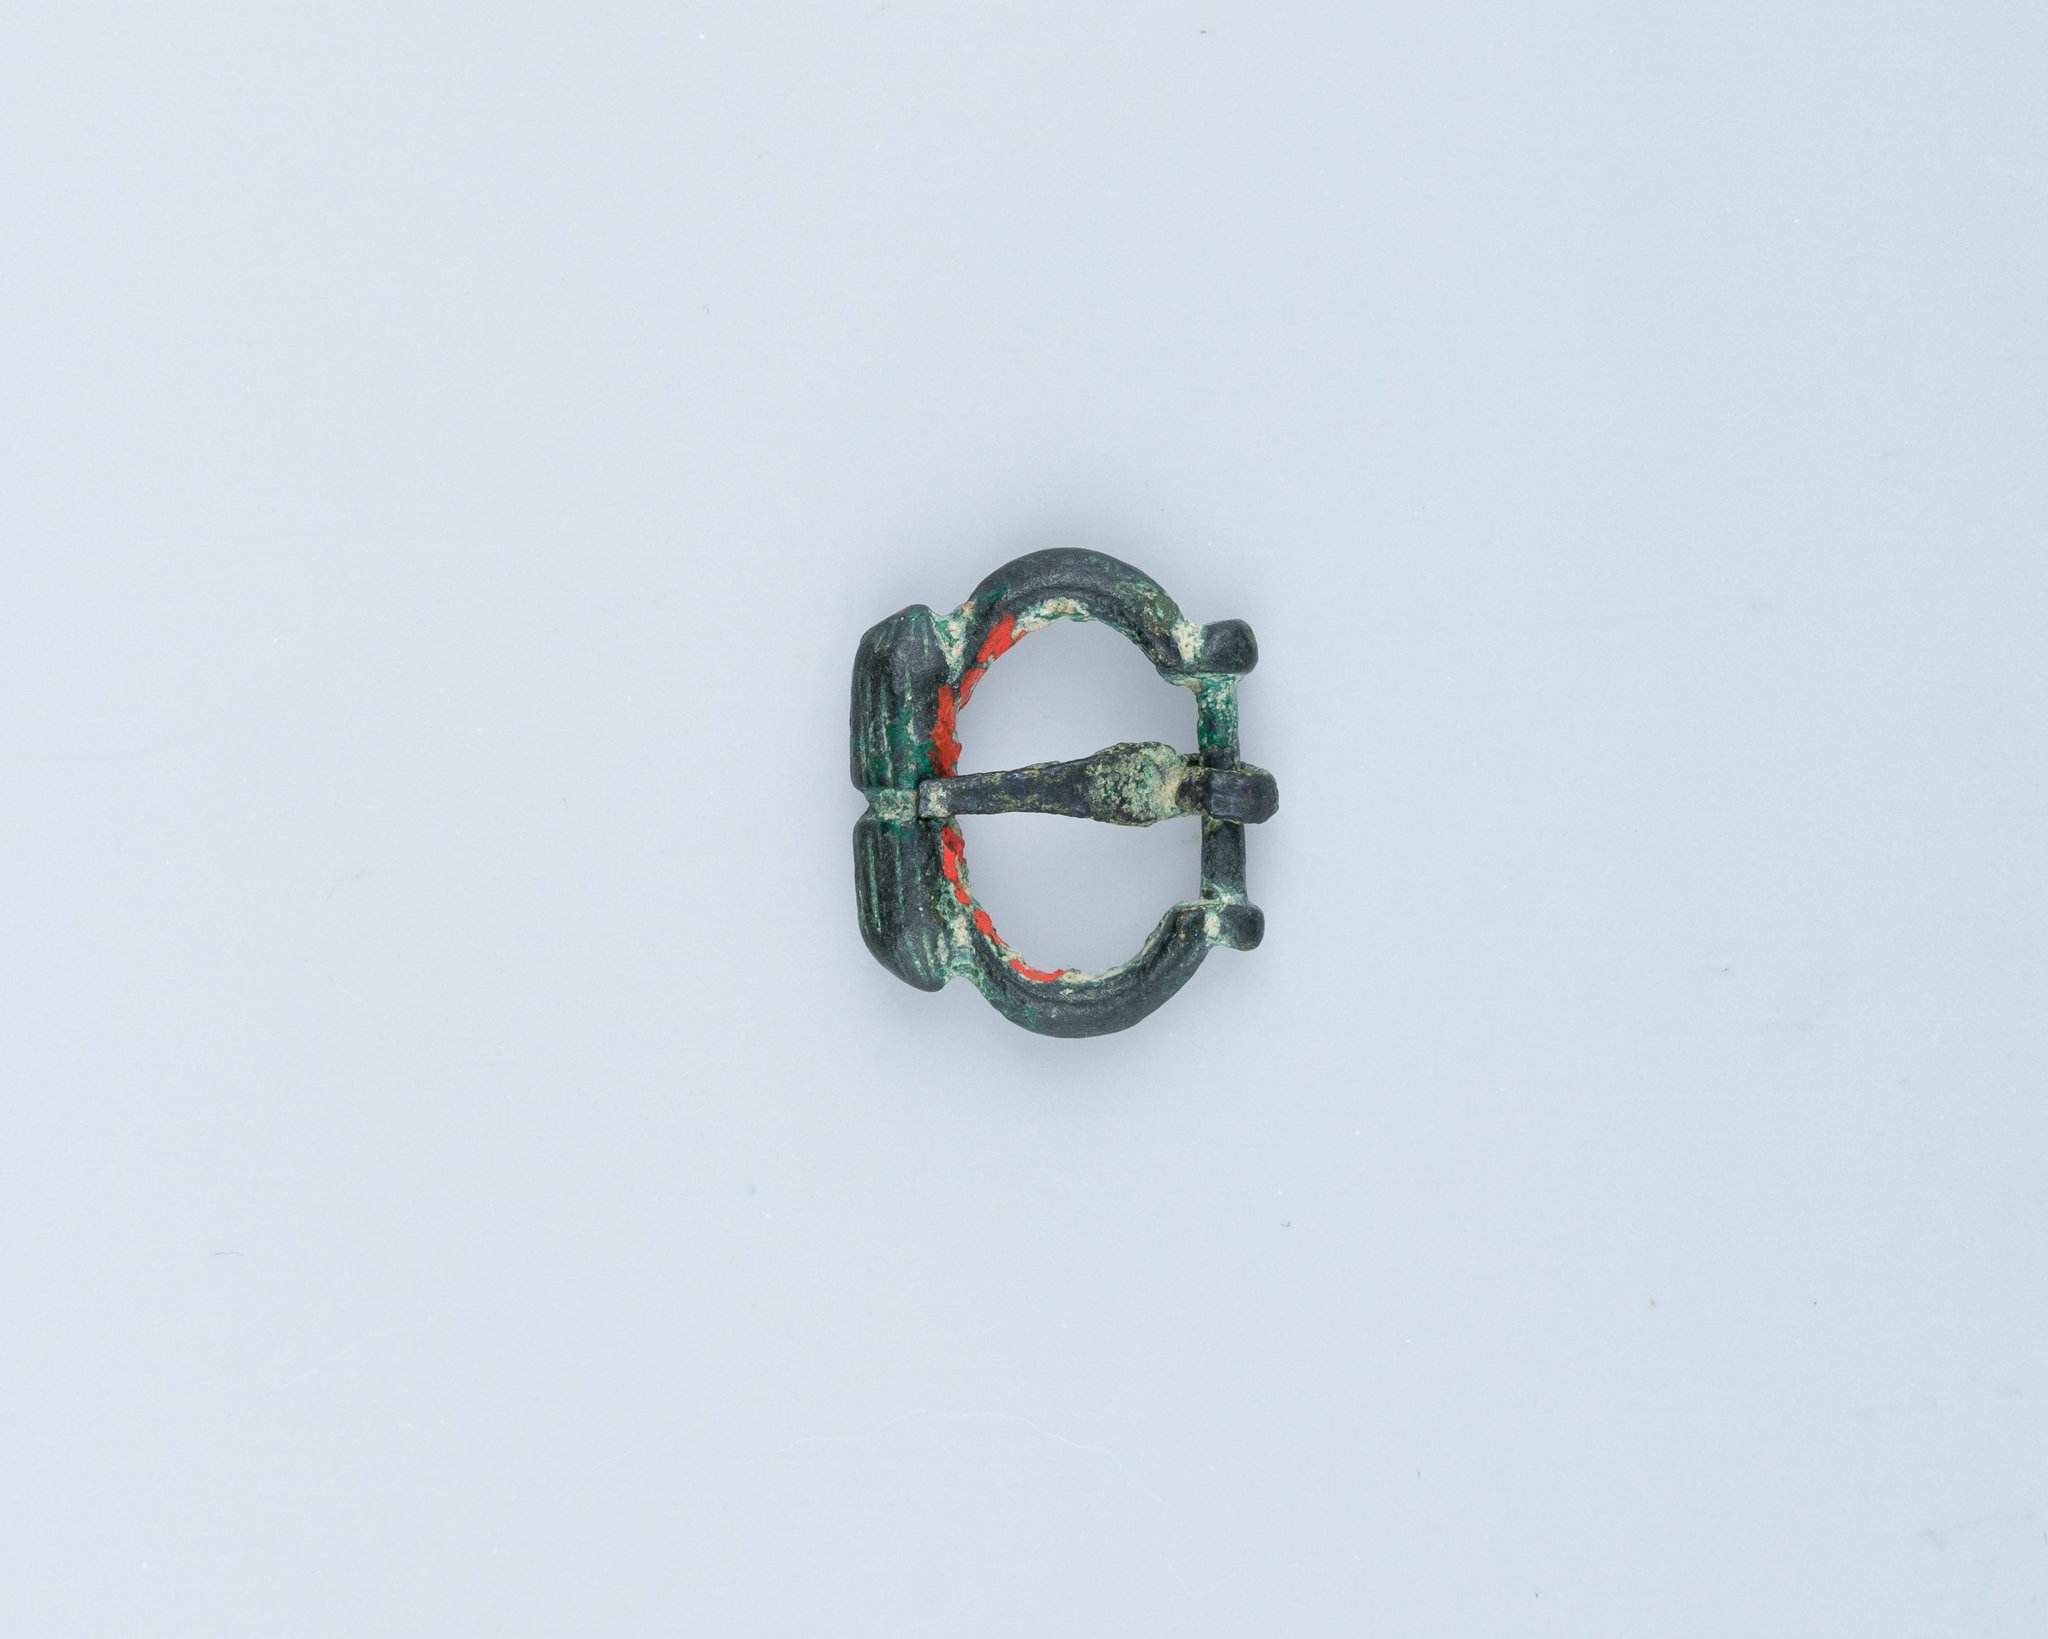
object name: buckle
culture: french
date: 1301-1400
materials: bronze, patina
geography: france